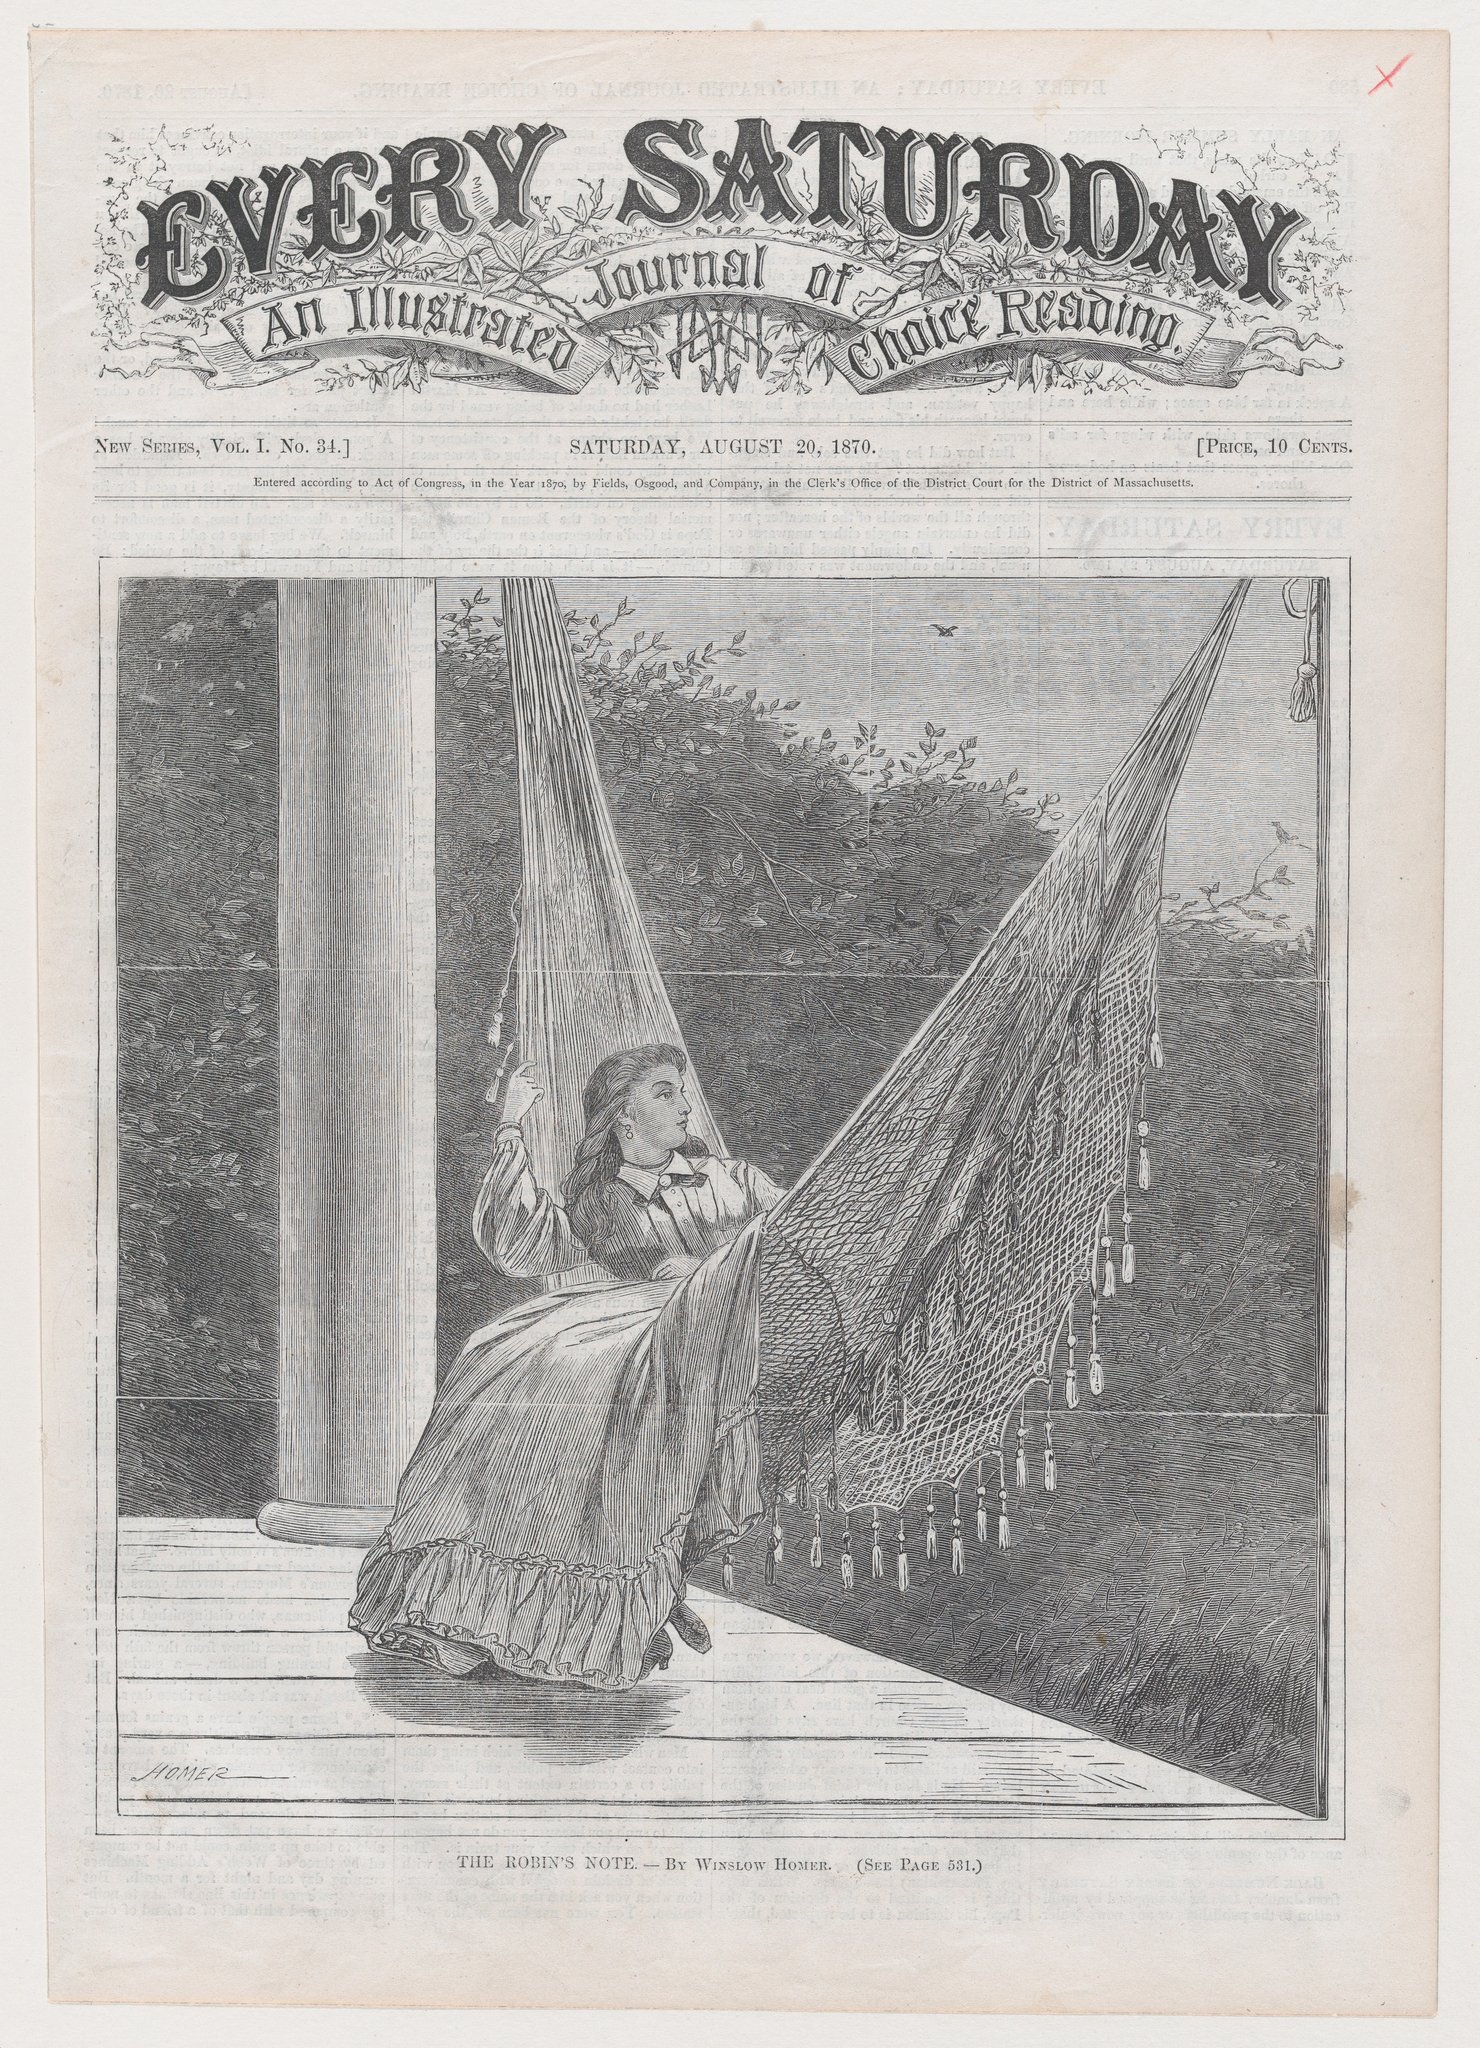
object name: print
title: The Robin's Note (from "Every Saturday," Vol. I, New Series)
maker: winslow homer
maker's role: artist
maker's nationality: american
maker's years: 1836-1910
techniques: engraving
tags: women